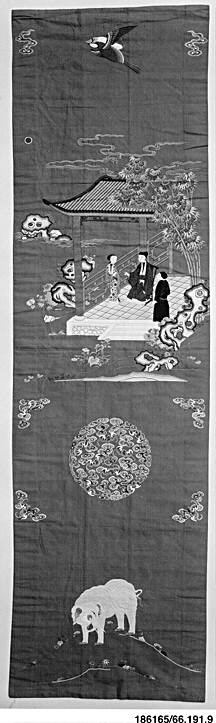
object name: chair strip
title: One of a Set of Twelve Chair Strips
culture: chinese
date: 1736-1795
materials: metal thread, silk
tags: birds,men,women,elephants,pavilions